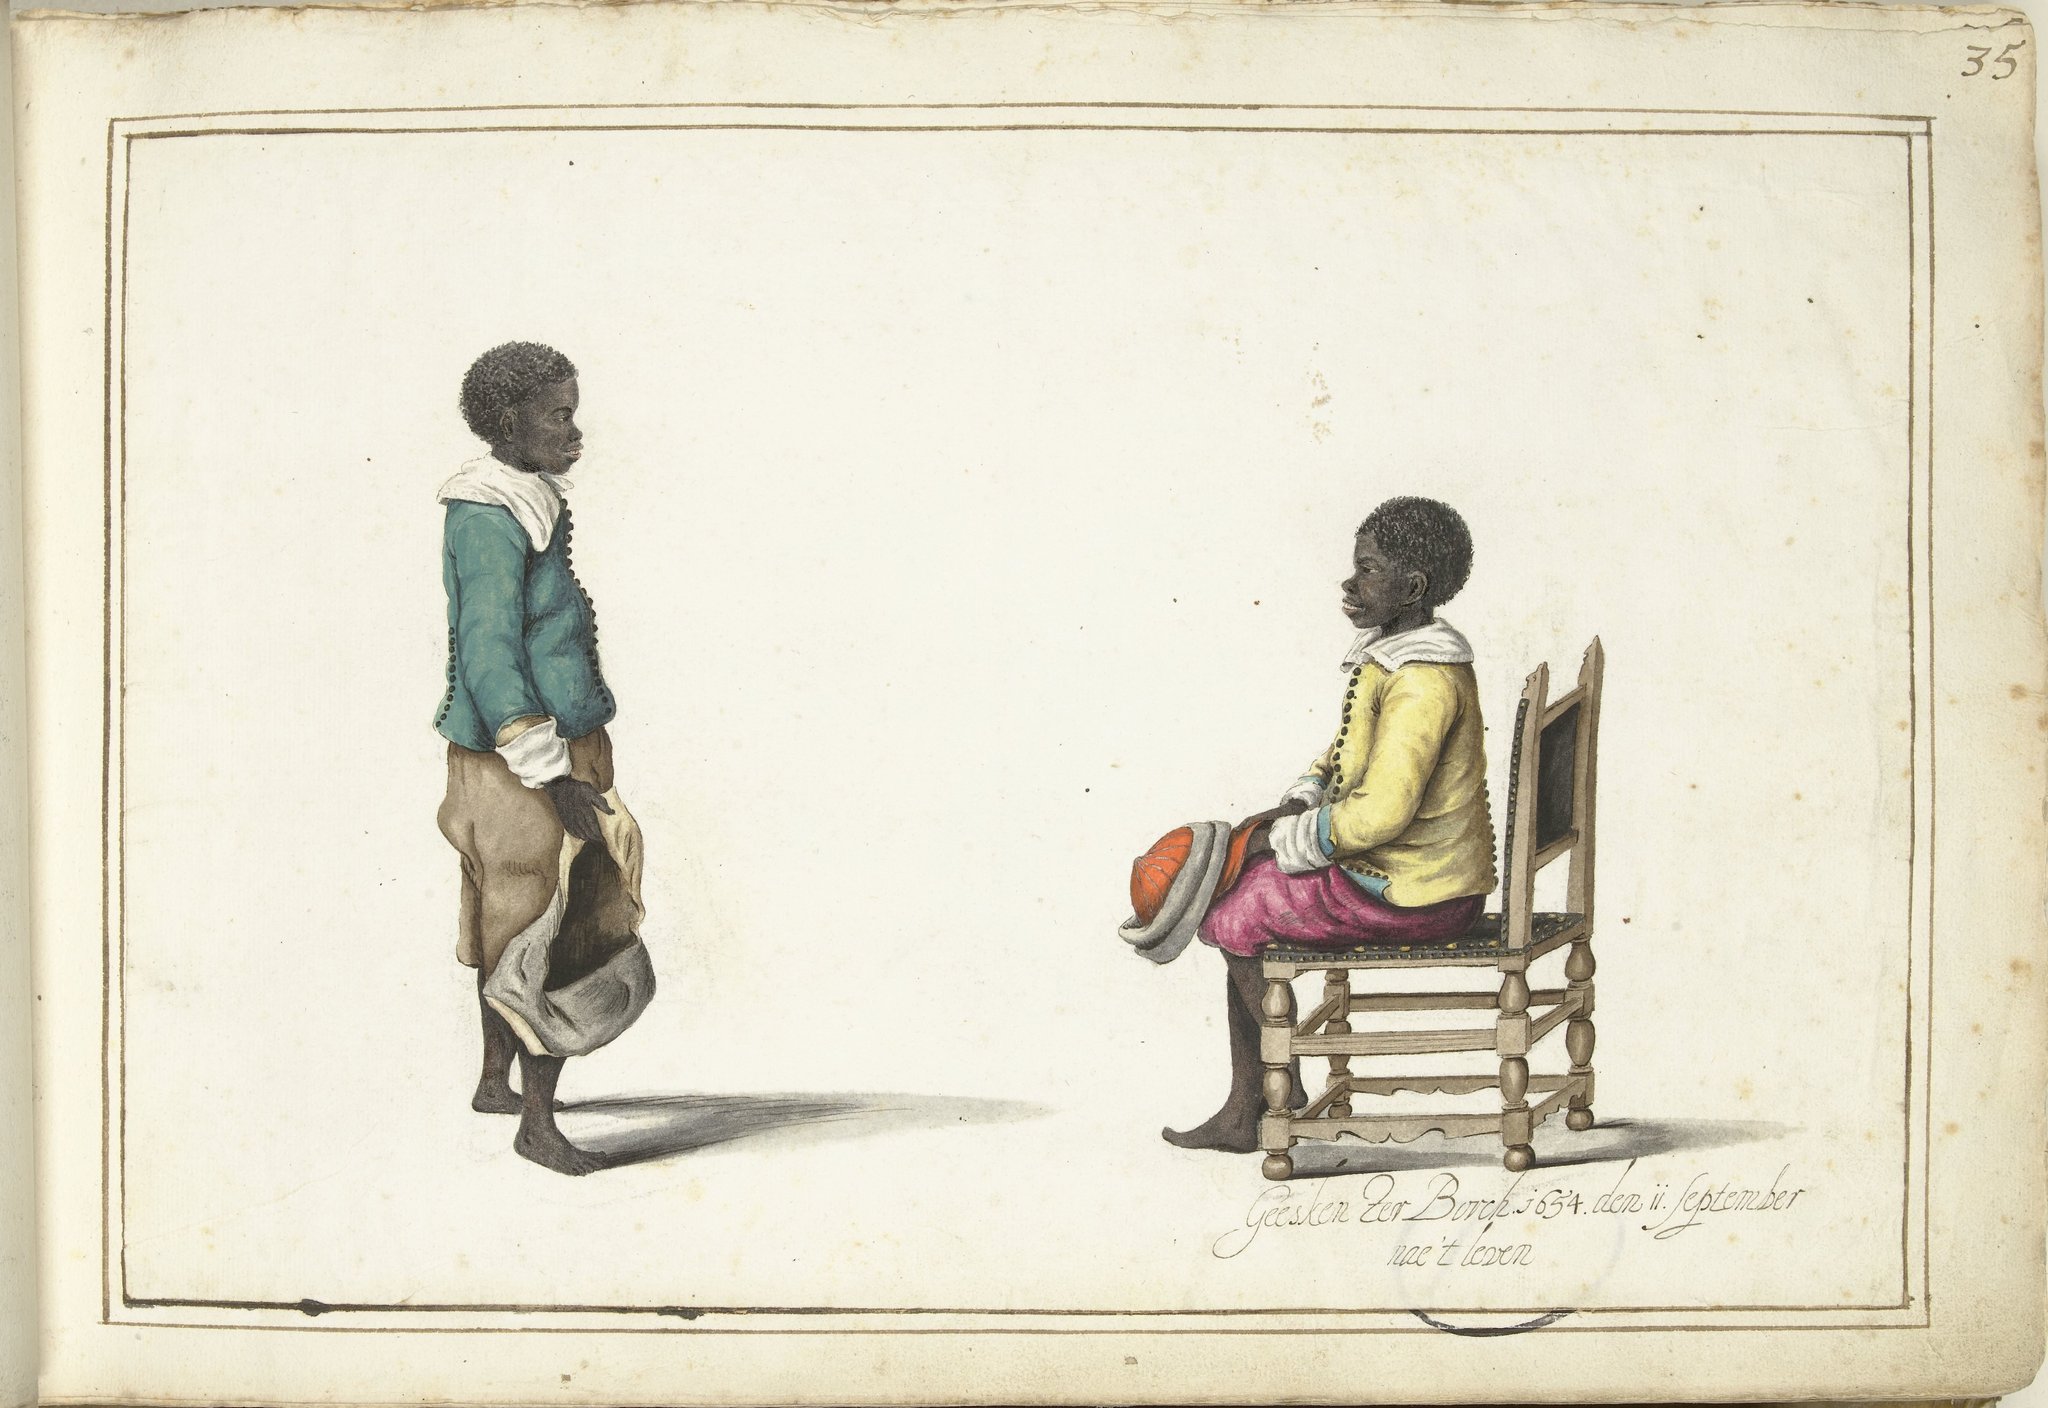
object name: drawing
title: Twee Afrikaanse jongetjes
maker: gesina ter borch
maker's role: draughtsman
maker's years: 1633-1690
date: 1654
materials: ink, paper, watercolor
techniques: brush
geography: zwolle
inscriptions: signature and date: ‘Geesken ter Borch 1654. den 11.september’, annotation: ‘nae 't leven’